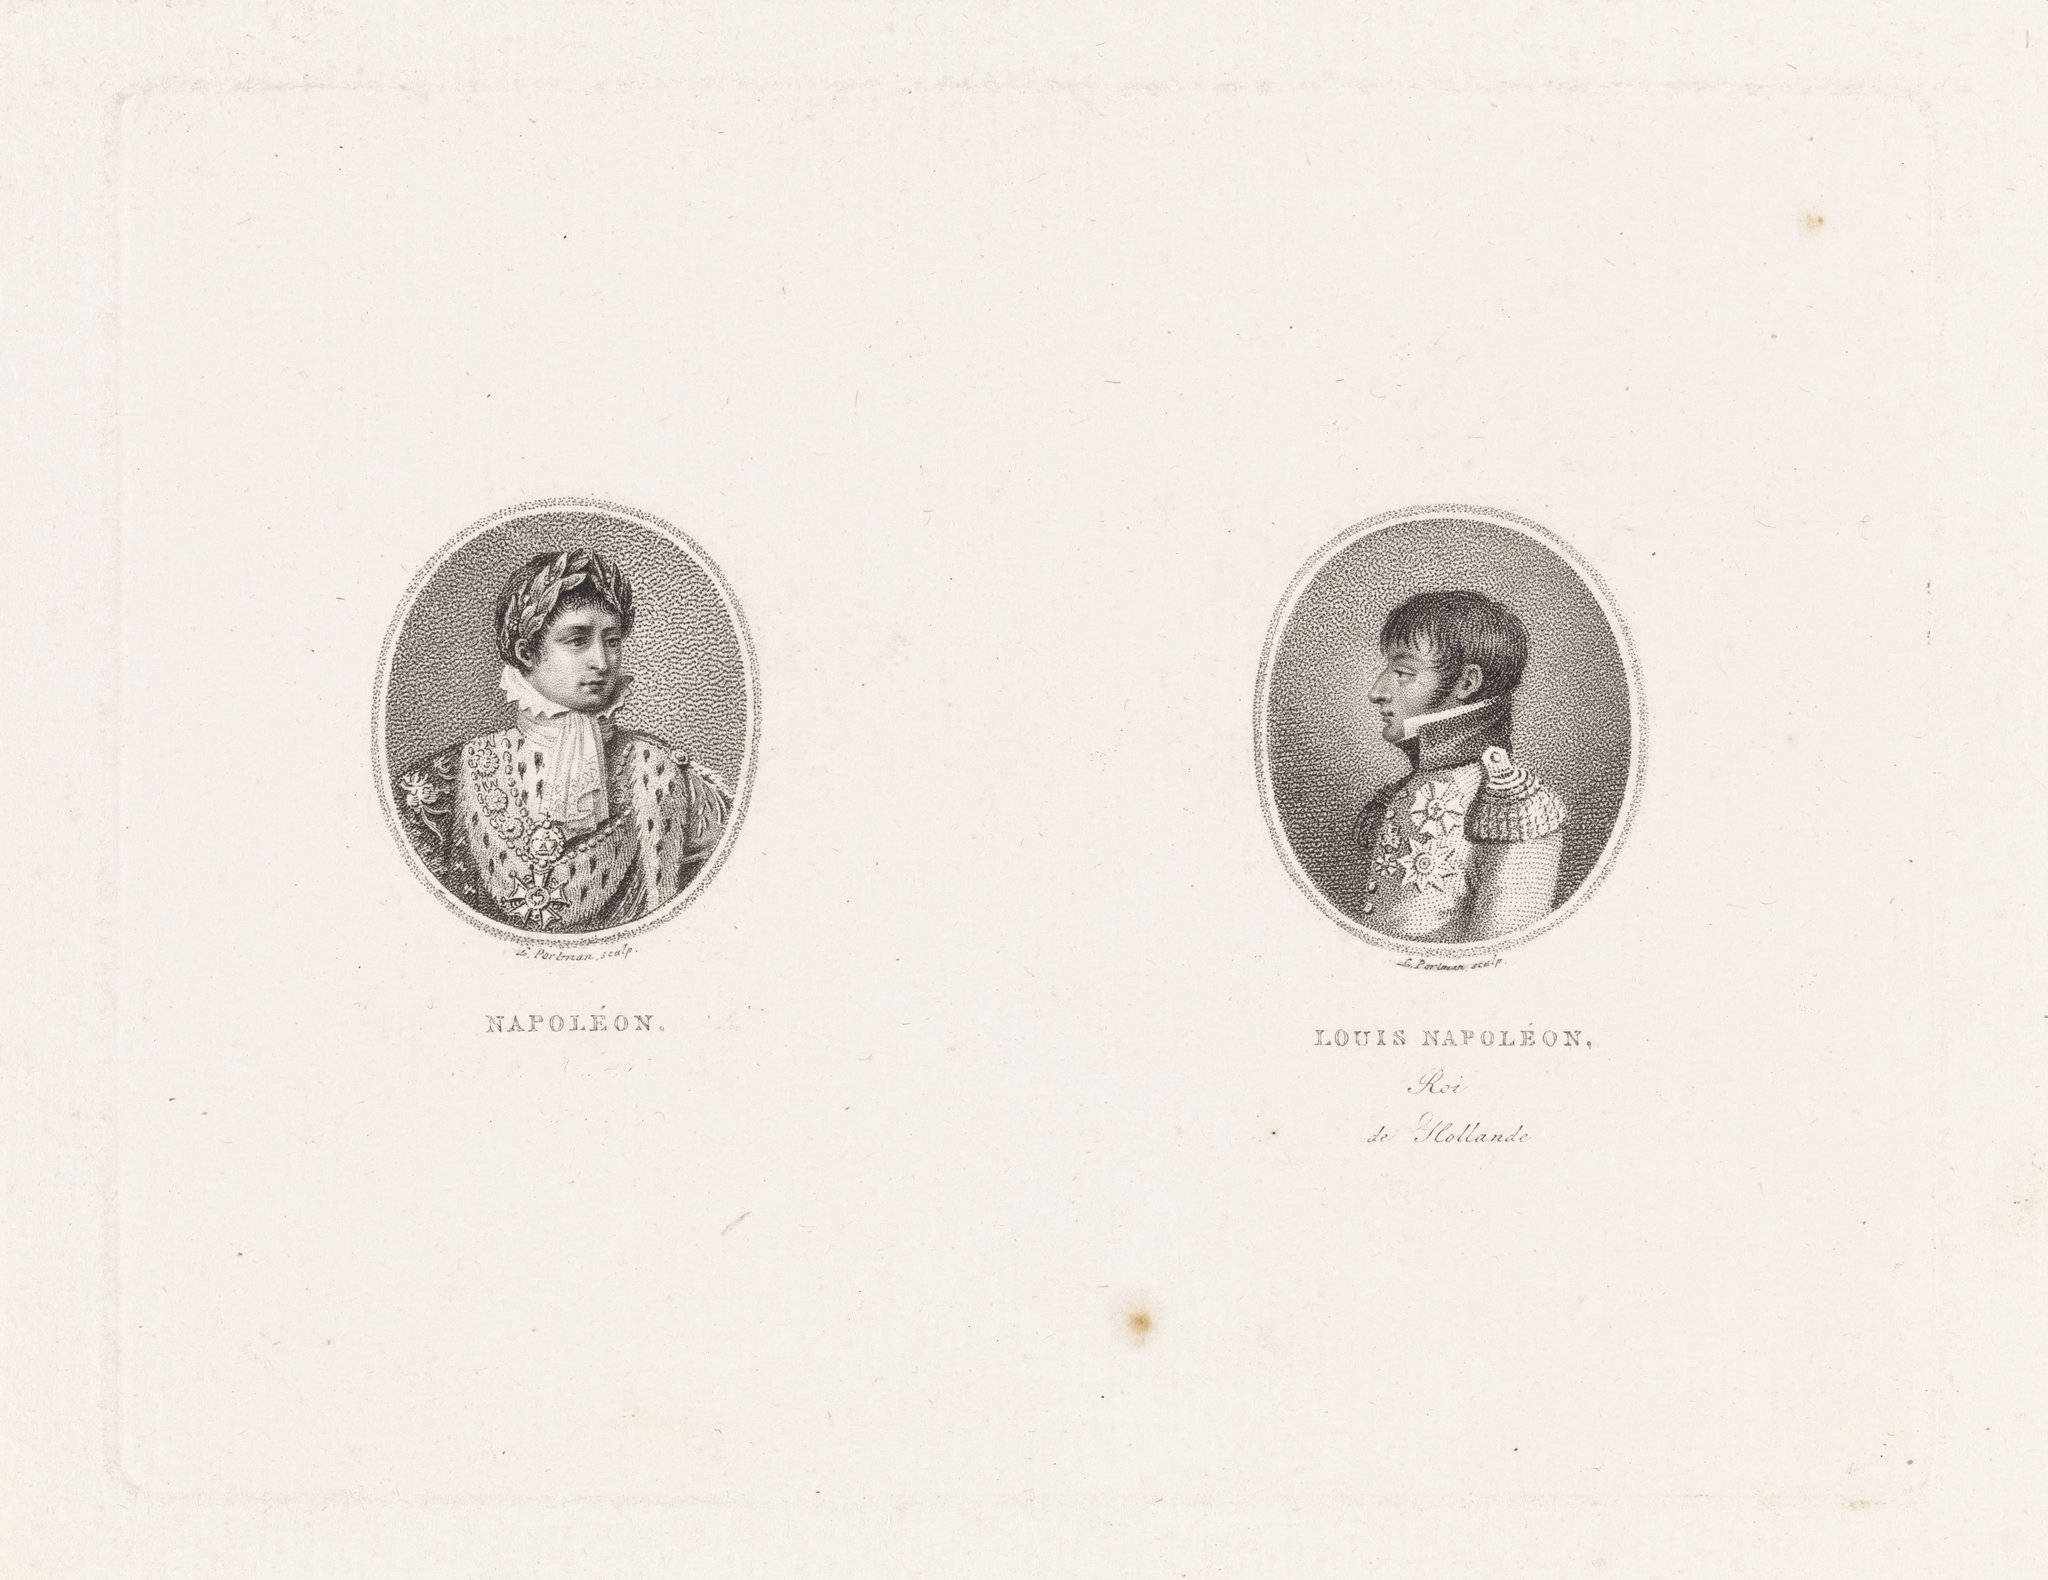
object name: print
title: Dubbelportret van Napoleon I Bonaparte en Lodewijk Napoleon Bonaparte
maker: ludwig gottlieb portman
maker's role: print maker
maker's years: 1772-1828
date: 1806-1828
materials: paper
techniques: etching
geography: amsterdam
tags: louis napoleon (king of holland), napoleon i (emperor of the french), knighthood order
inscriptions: collector's mark: Lugt 2228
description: Links: Portret van Napoleon I Bonaparte, keizer der Fransen. Hij is gelauwerd en draagt zijn keizersmantel. Rechts: Portret van Lodewijk Napoleon Bonaparte, koning van Holland en broer van de keizer.